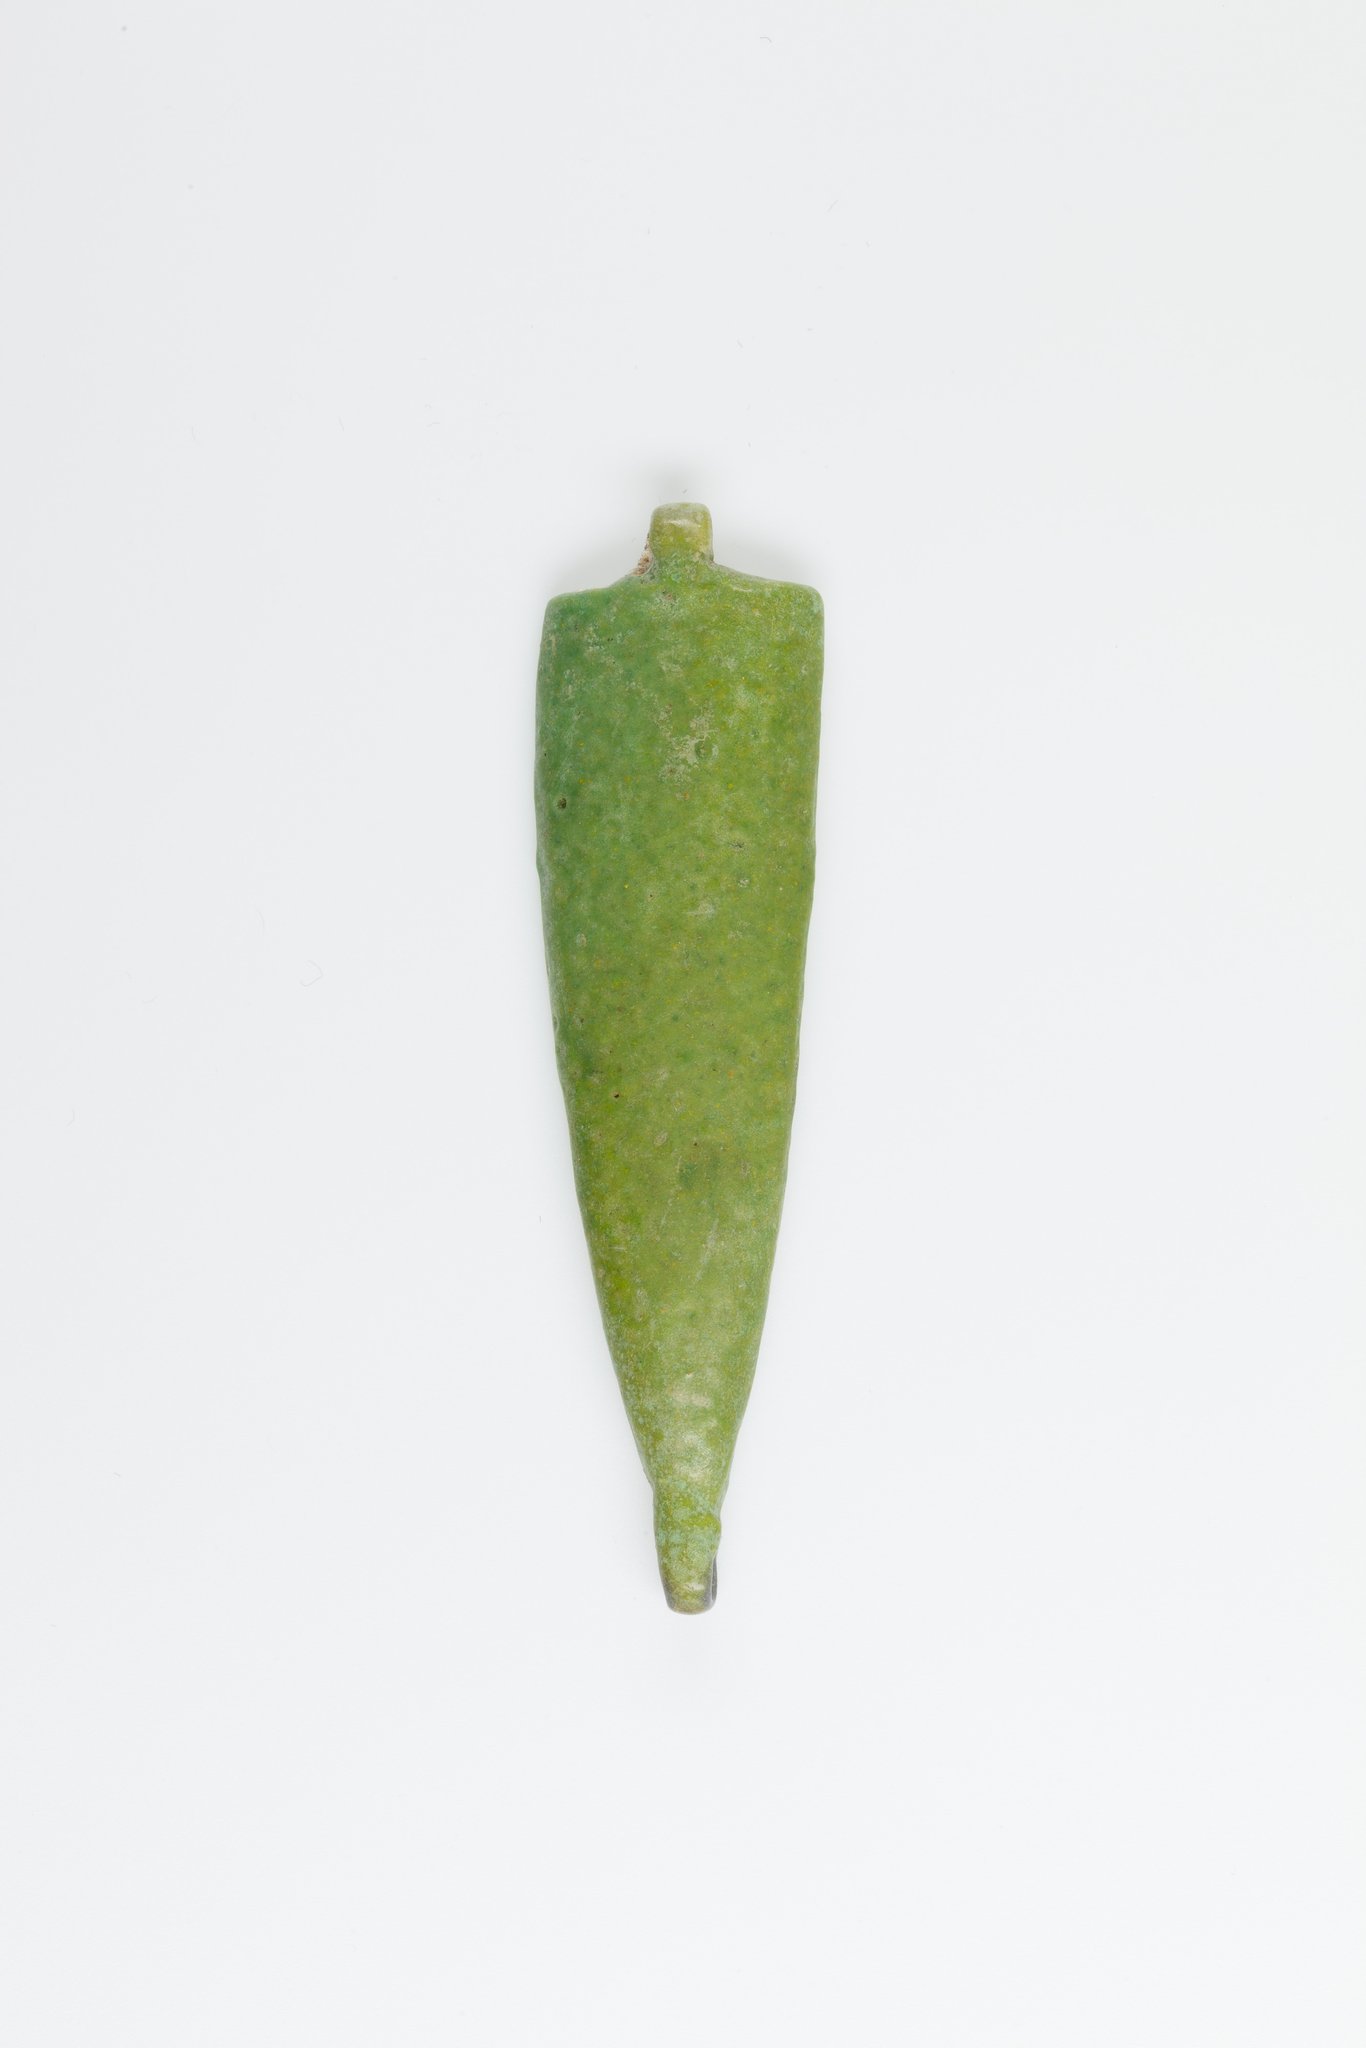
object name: pendant, leaf petal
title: Pendant: Lotus Sepal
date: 1390-1352 BCE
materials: faience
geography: egypt